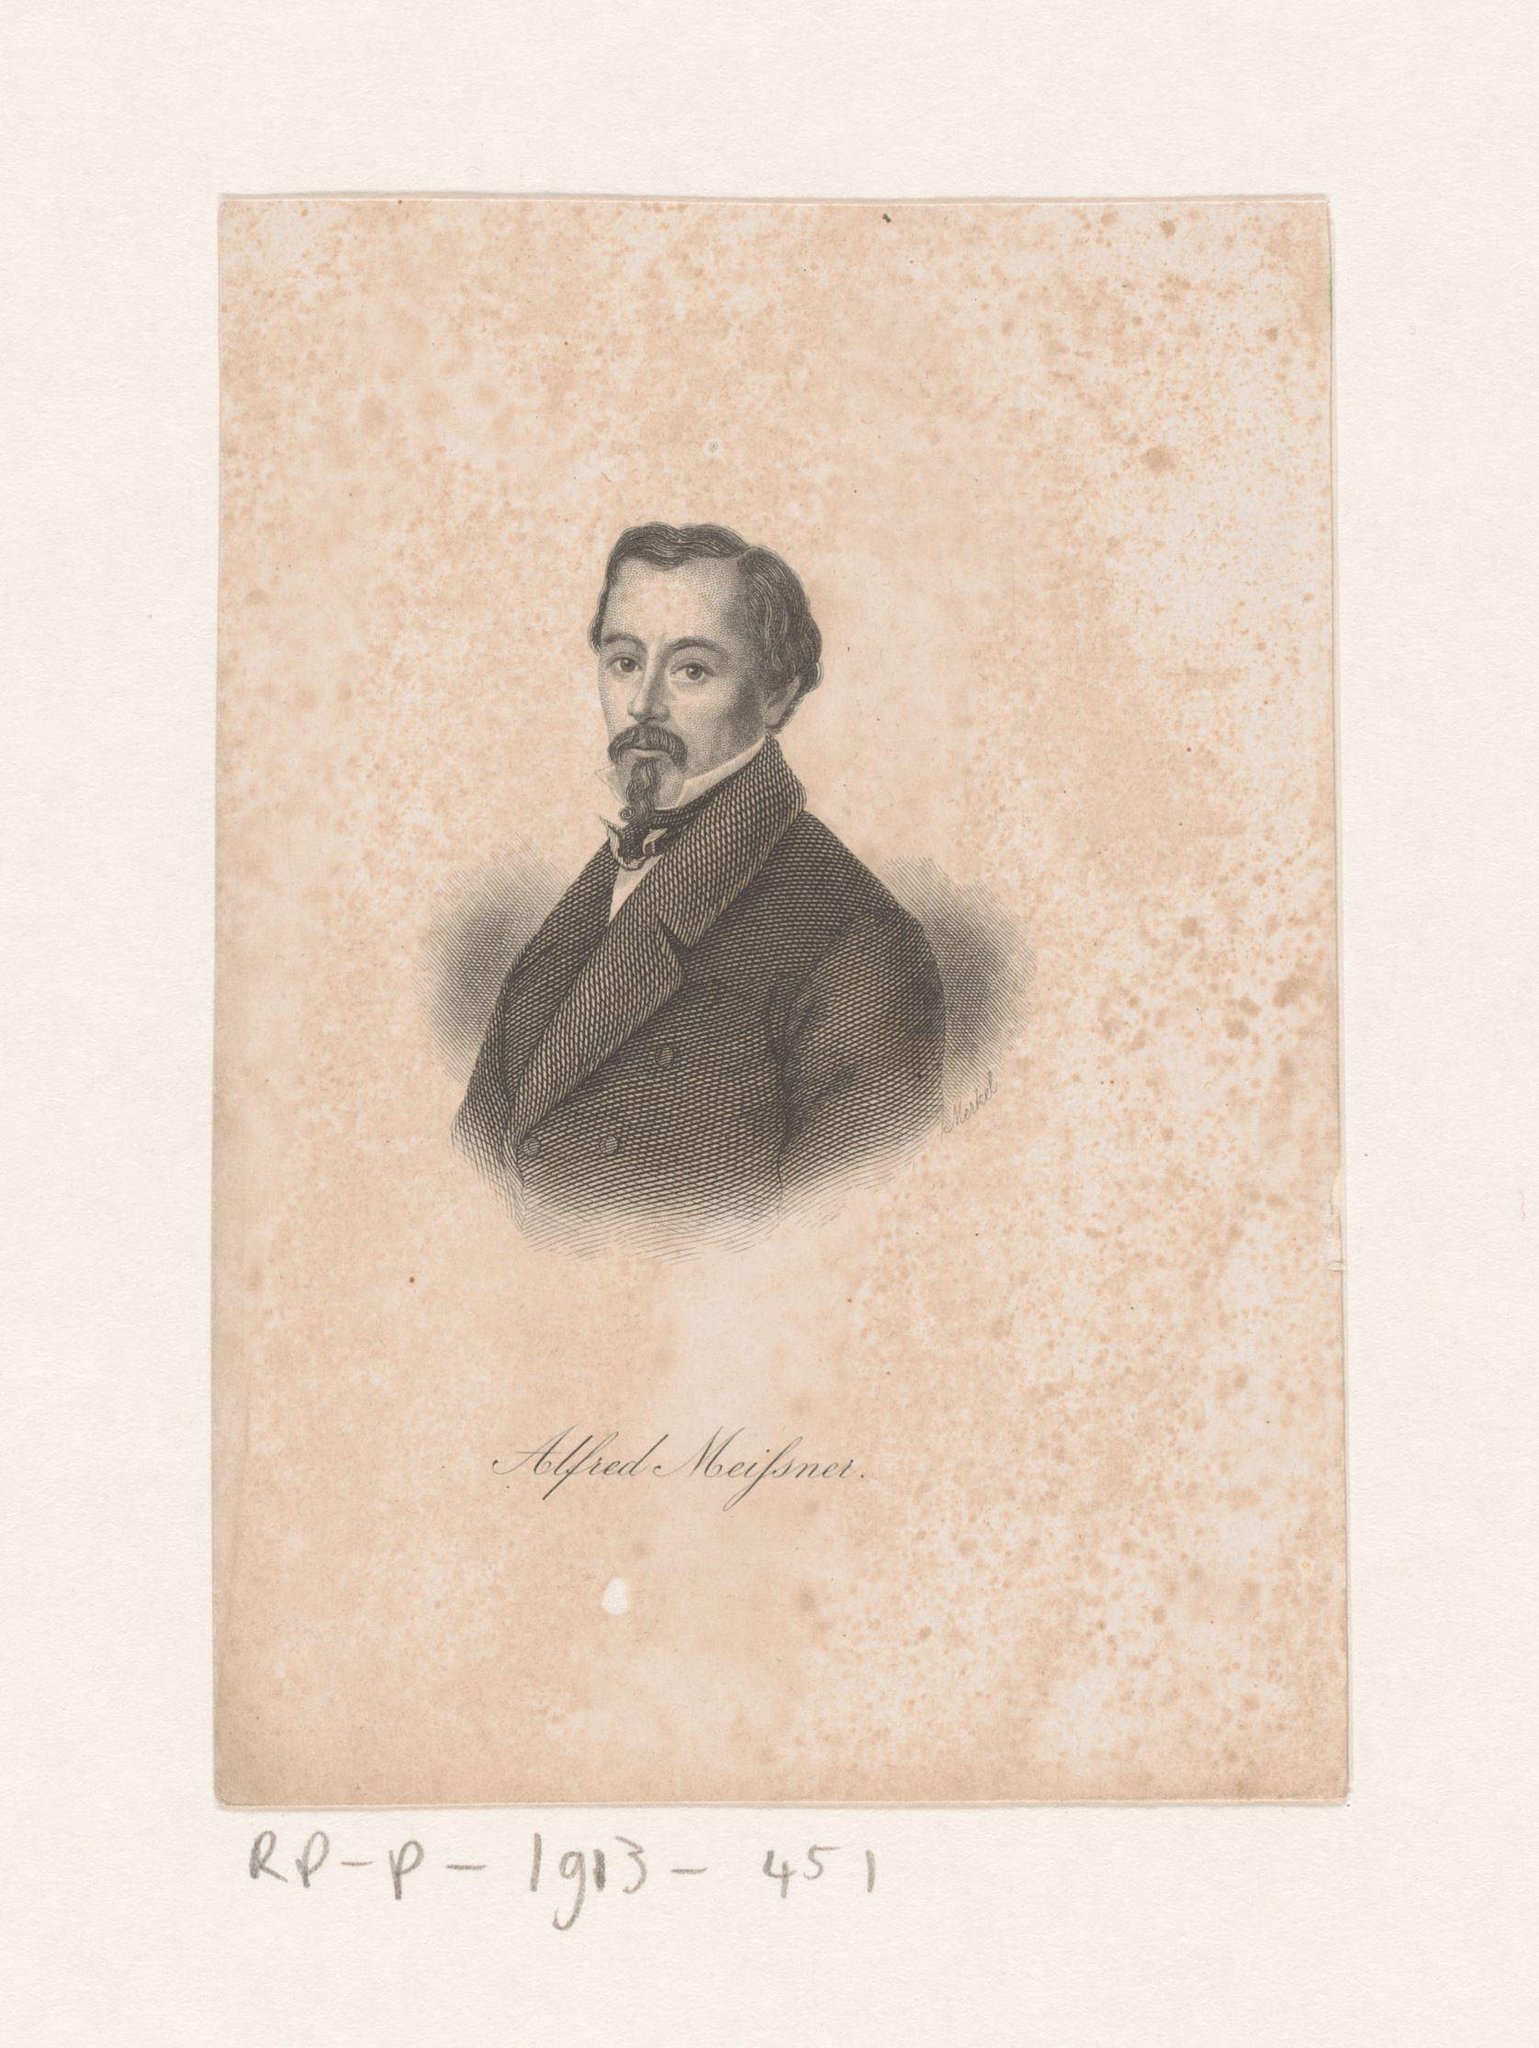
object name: print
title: Portret van Alfred Meissner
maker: conrad friedrich merckel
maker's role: print maker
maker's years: 1826-1880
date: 1836-1880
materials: paper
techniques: engraving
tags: austria, historical persons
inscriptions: collector's mark: Lugt 2228